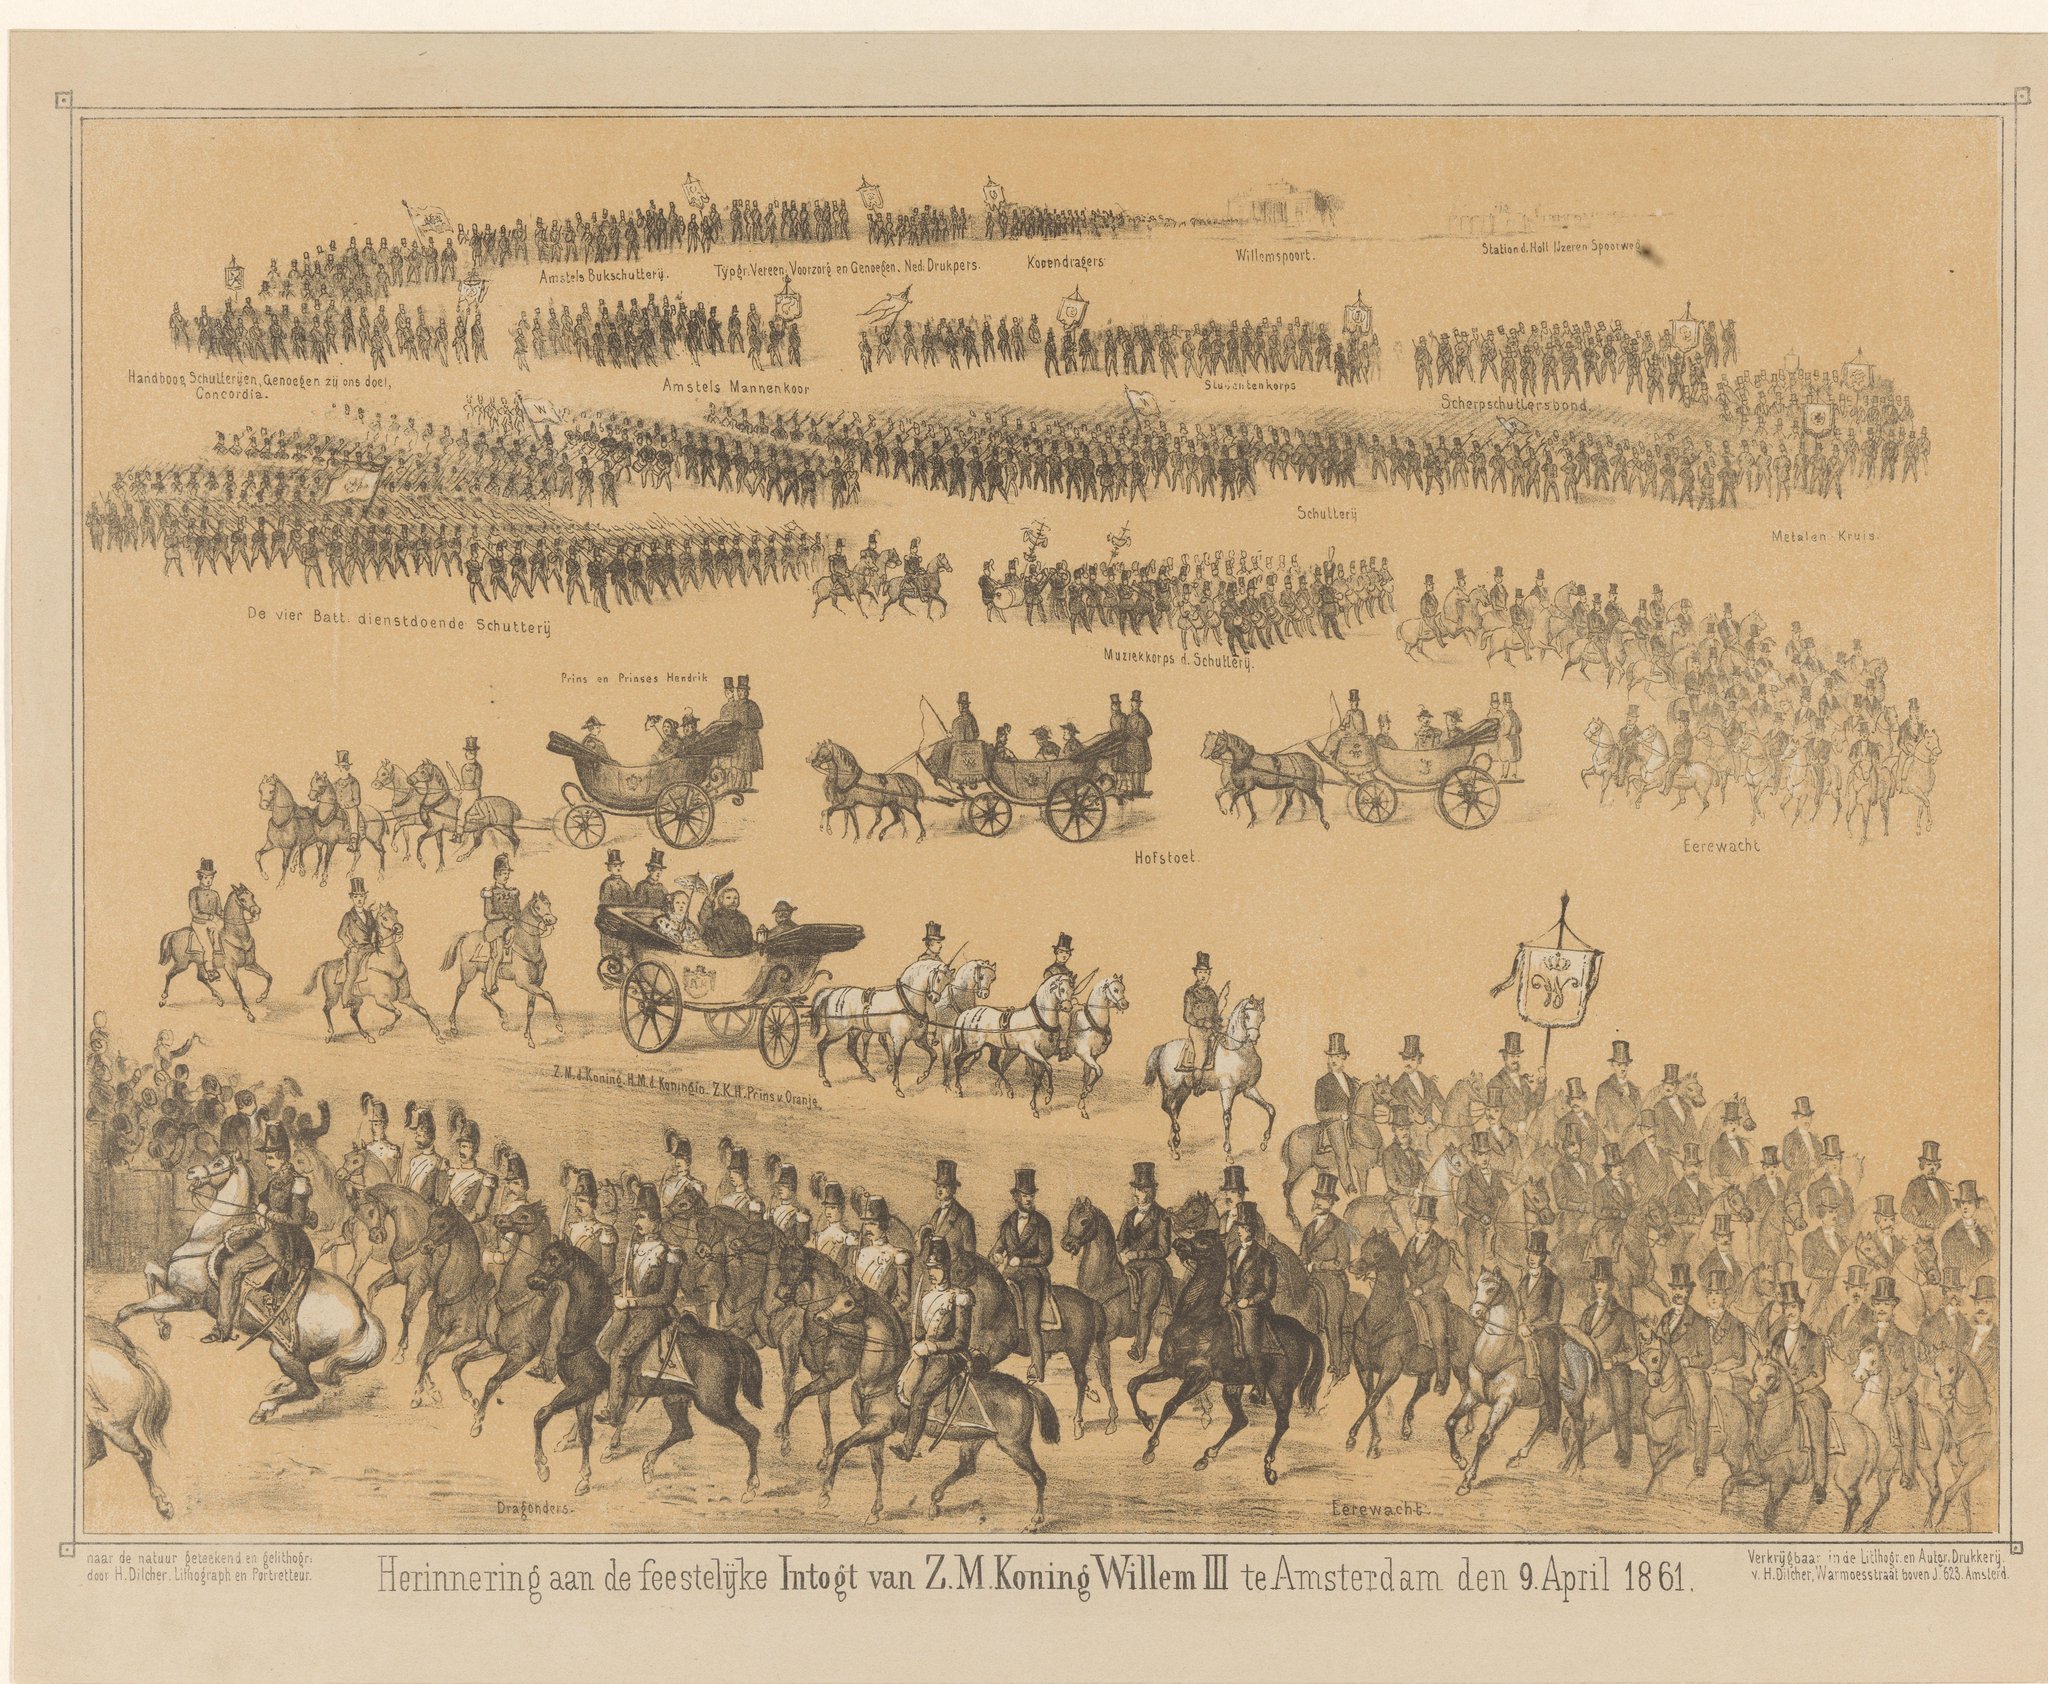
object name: print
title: Herinnering aan de feestelijke Intogt van Z.M. Willem III te Amsterdam den 9. April 1861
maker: heinrich dilcher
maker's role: print maker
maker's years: 1824-1885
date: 1861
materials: paper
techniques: tone lithography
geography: amsterdam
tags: brussels, willem iii (koning der nederlanden), the hague, paris, willem (prins der nederlanden), hendrik (prins der nederlanden), sophia frederika mathilda van württemberg, public festivities on the occasion of royal events, military parade, pageant, amsterdam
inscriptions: collector's mark: Lugt 2228, collector's mark: Lugt 2760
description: Feestelijke intocht van koning Willem III te Amsterdam op 9 april 1861. De onderdelen van de stoet afgebeeld in rijen boven elkaar. Onderaan dragonders en de erewacht, daarboven het rijtuig met de koning, koningin en kroonprins, rijtuigen met de prinsen gevolgd door muziekkorps en schutterijen.